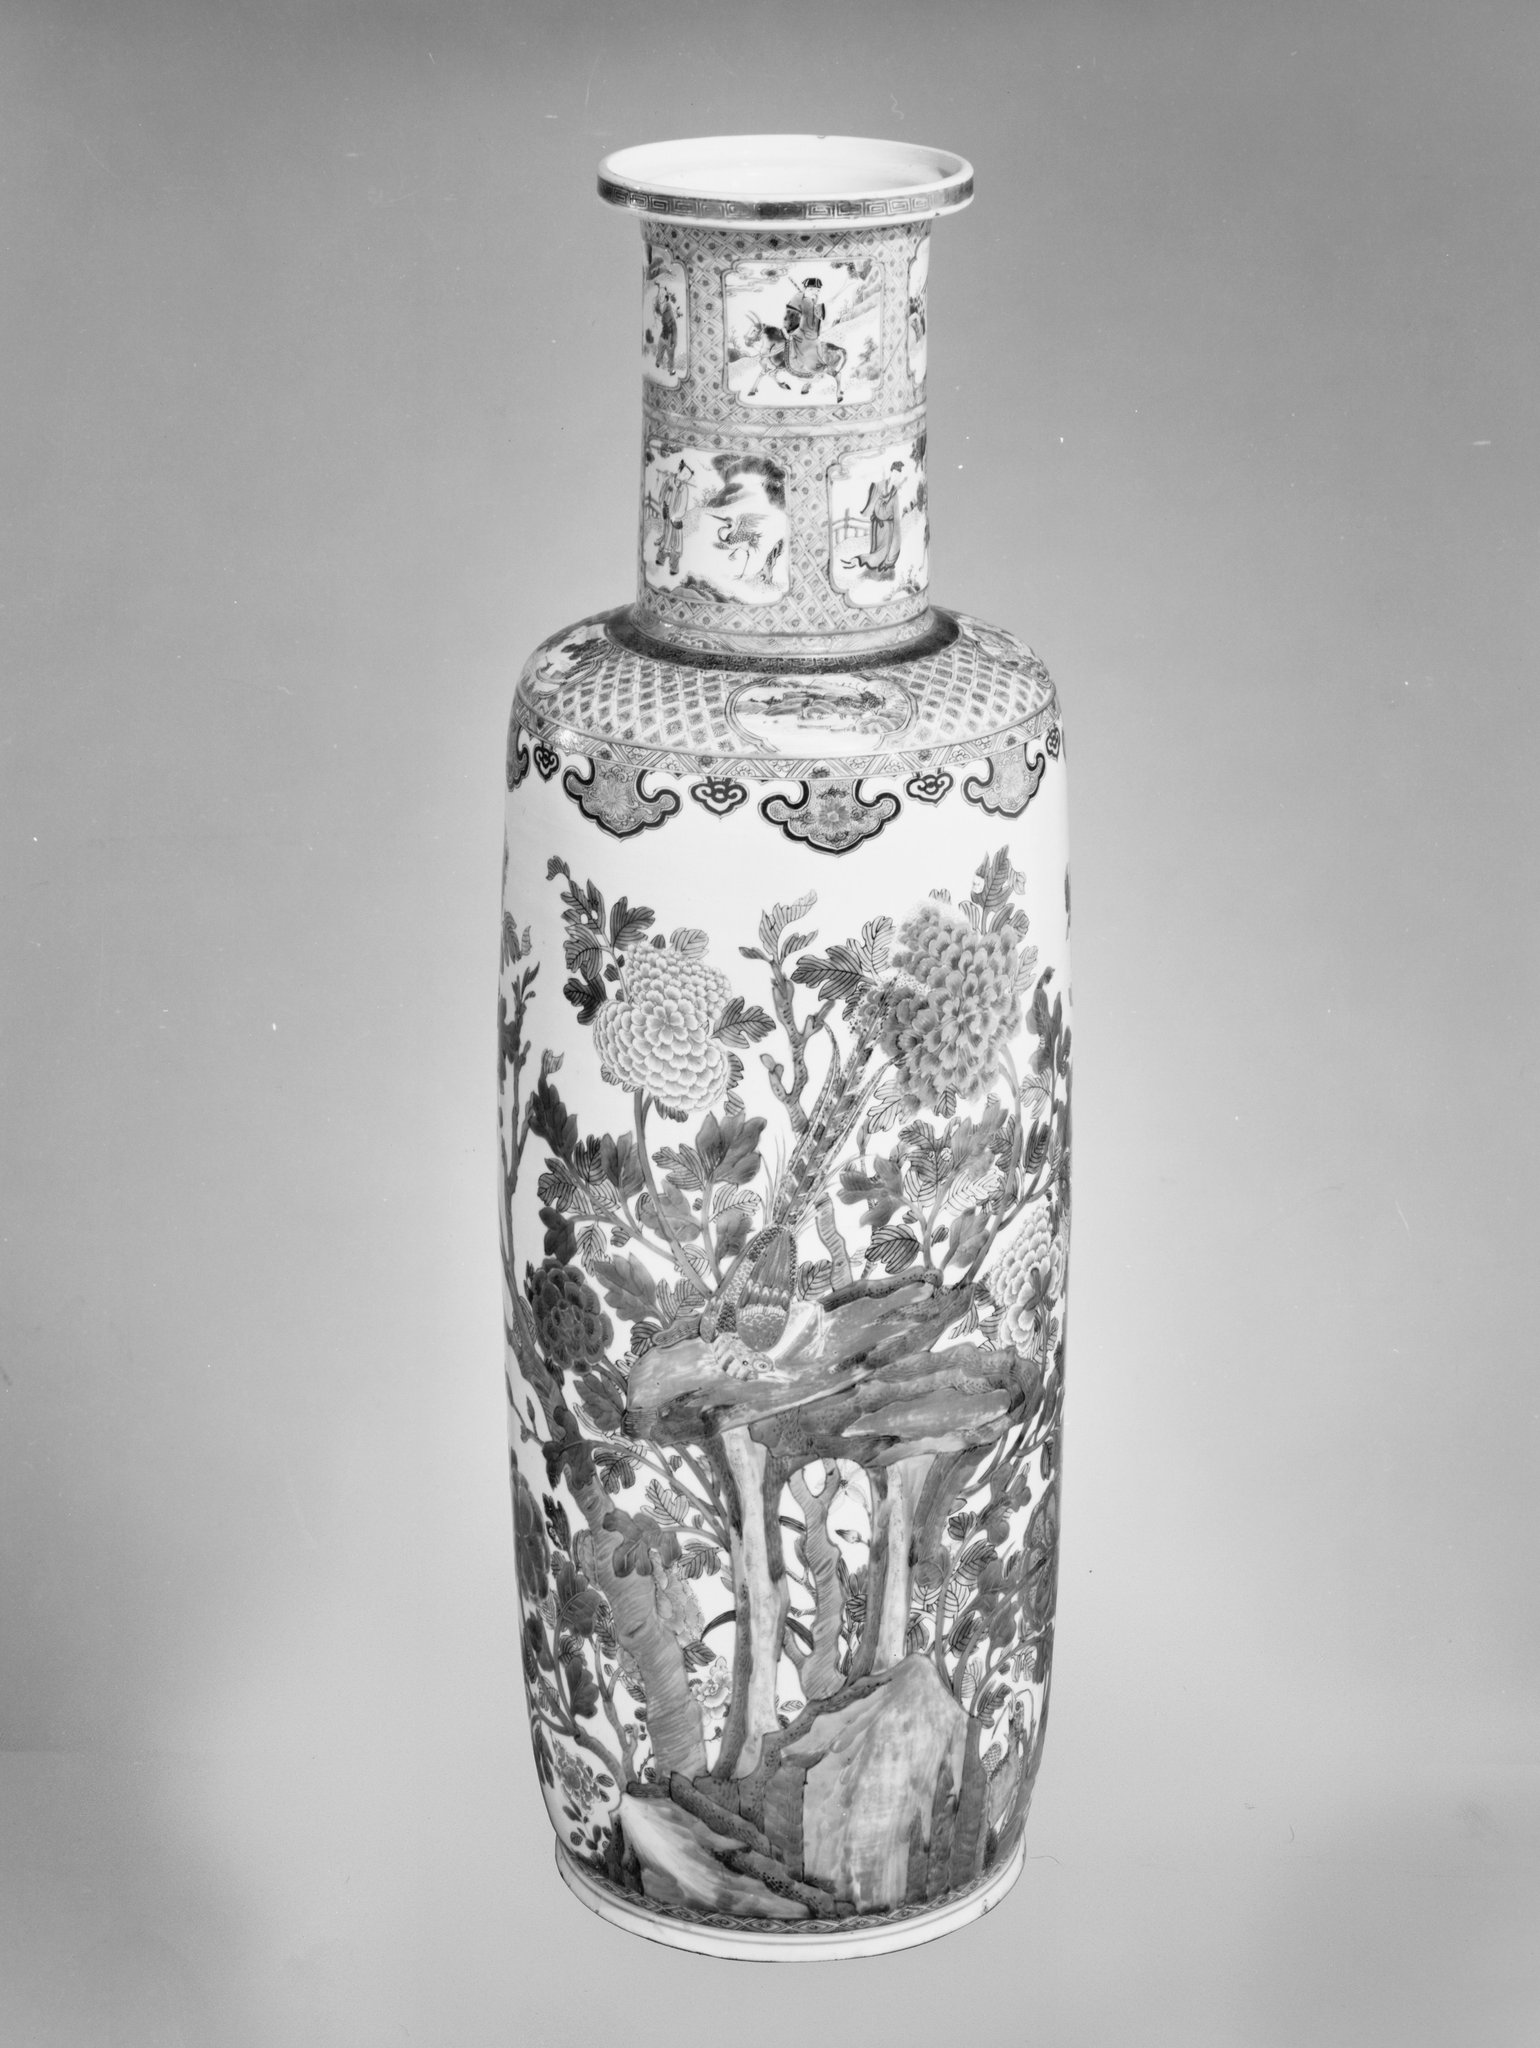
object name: vase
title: Vase with birds and flowers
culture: chinese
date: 1667-1733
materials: cobalt, enamel, gilt, porcelain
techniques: overglaze, painting, polychrome, underglaze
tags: flowers